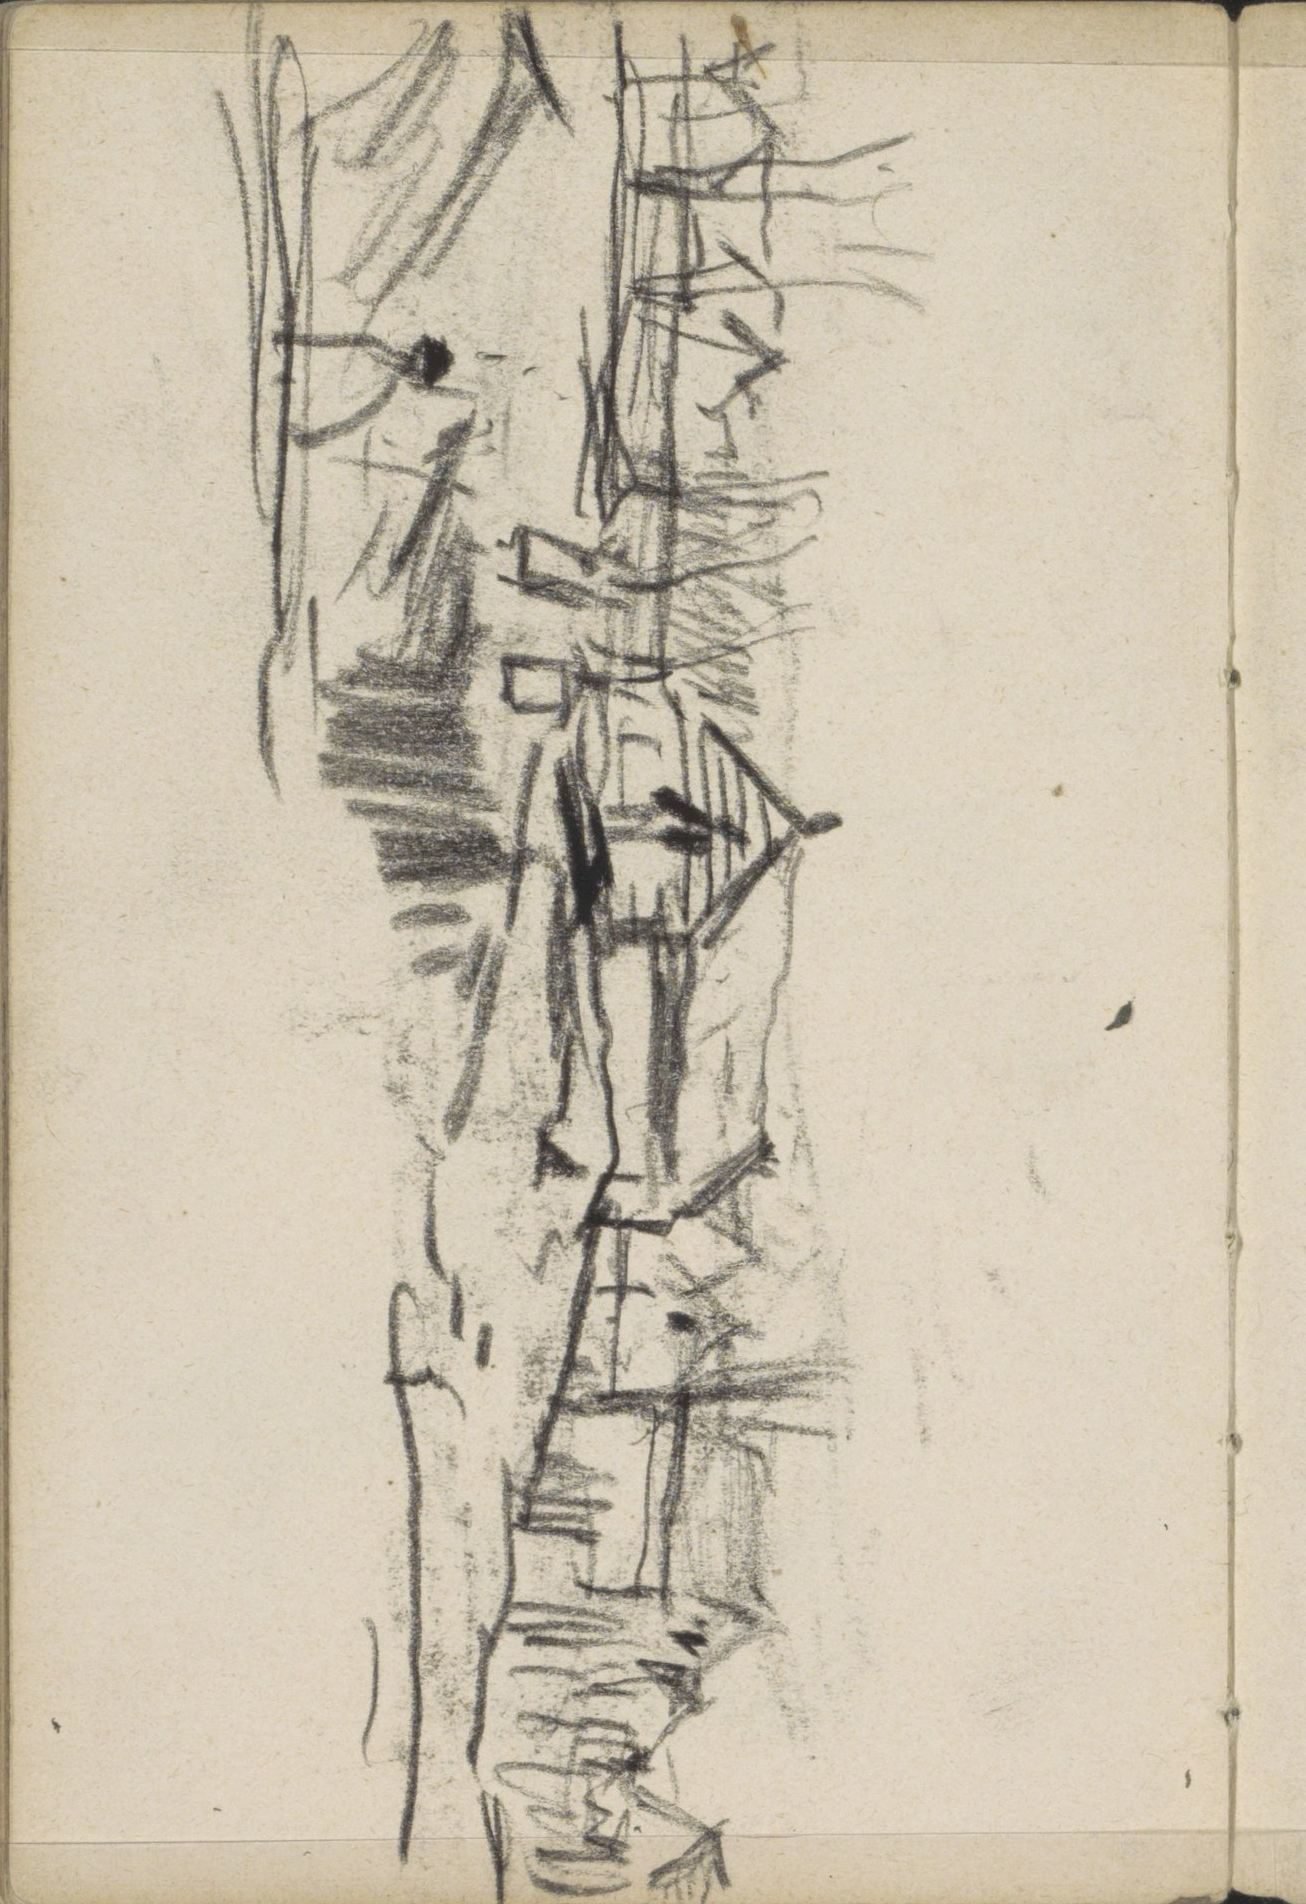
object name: sketchbook leaf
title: Gezicht op huizen langs het Rustenburgerpad te Amsterdam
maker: george hendrik breitner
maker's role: draughtsman, painter, print maker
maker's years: 1857-1923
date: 1907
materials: chalk, paper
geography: amsterdam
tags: rural housing, e.g. country-house, villa, cottage, church (exterior)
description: Gezicht op huizen langs het Rustenburgerpad te Amsterdam. In het midden mogelijk de R.K. Hulpkerk St. Willibrordus buiten de Veste. Vooraan een figuur. Pagina 89 uit een schetsboek met 46 bladen vervaardigd in Amsterdam, Rotterdam en Haarlem.